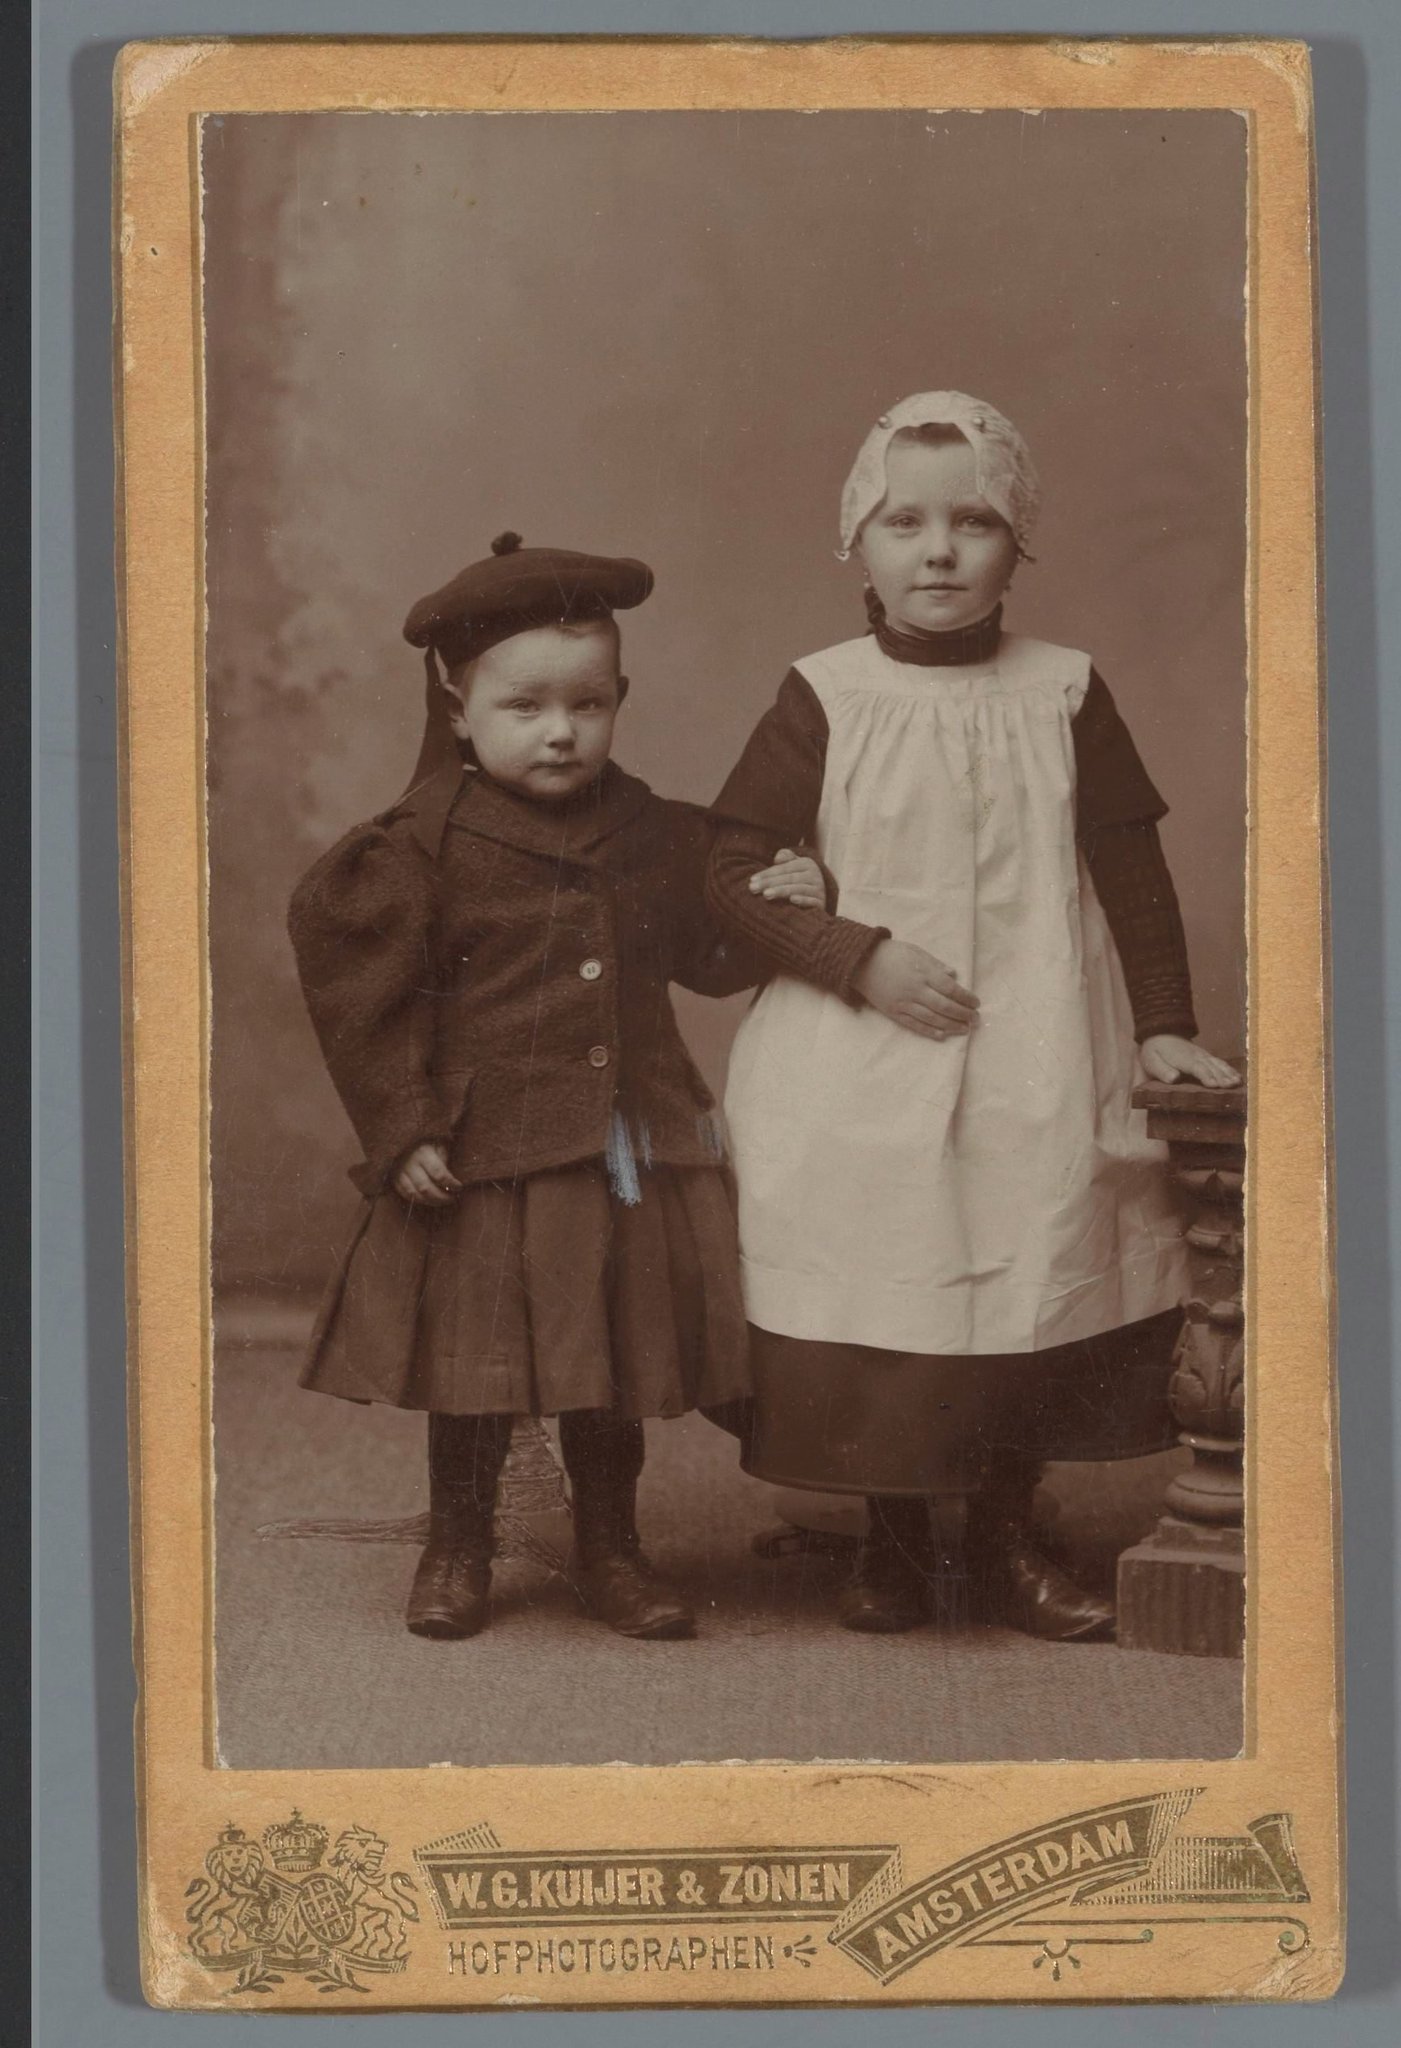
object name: carte de visite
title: Portret van twee onbekende kinderen in klederdracht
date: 1884-1906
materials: paper, cardboard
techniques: gelatin silver print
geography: amsterdam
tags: child, anonymous historical person portrayed, folk costume, regional costume, amsterdam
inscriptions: inscription: ‘W.G. Kuijer & Zonen/ Amsterdam/ Hofphotographen’, inscription: ‘Opgericht 1864/ Amsterdam/ Westermarkt 19/ W.G. Kuijer & Zonen/ Hofphotographen/ Spéciale inrichting/ voor/ vergrootingen/ in alle formaten./ B.P. Grimaud Paris.’